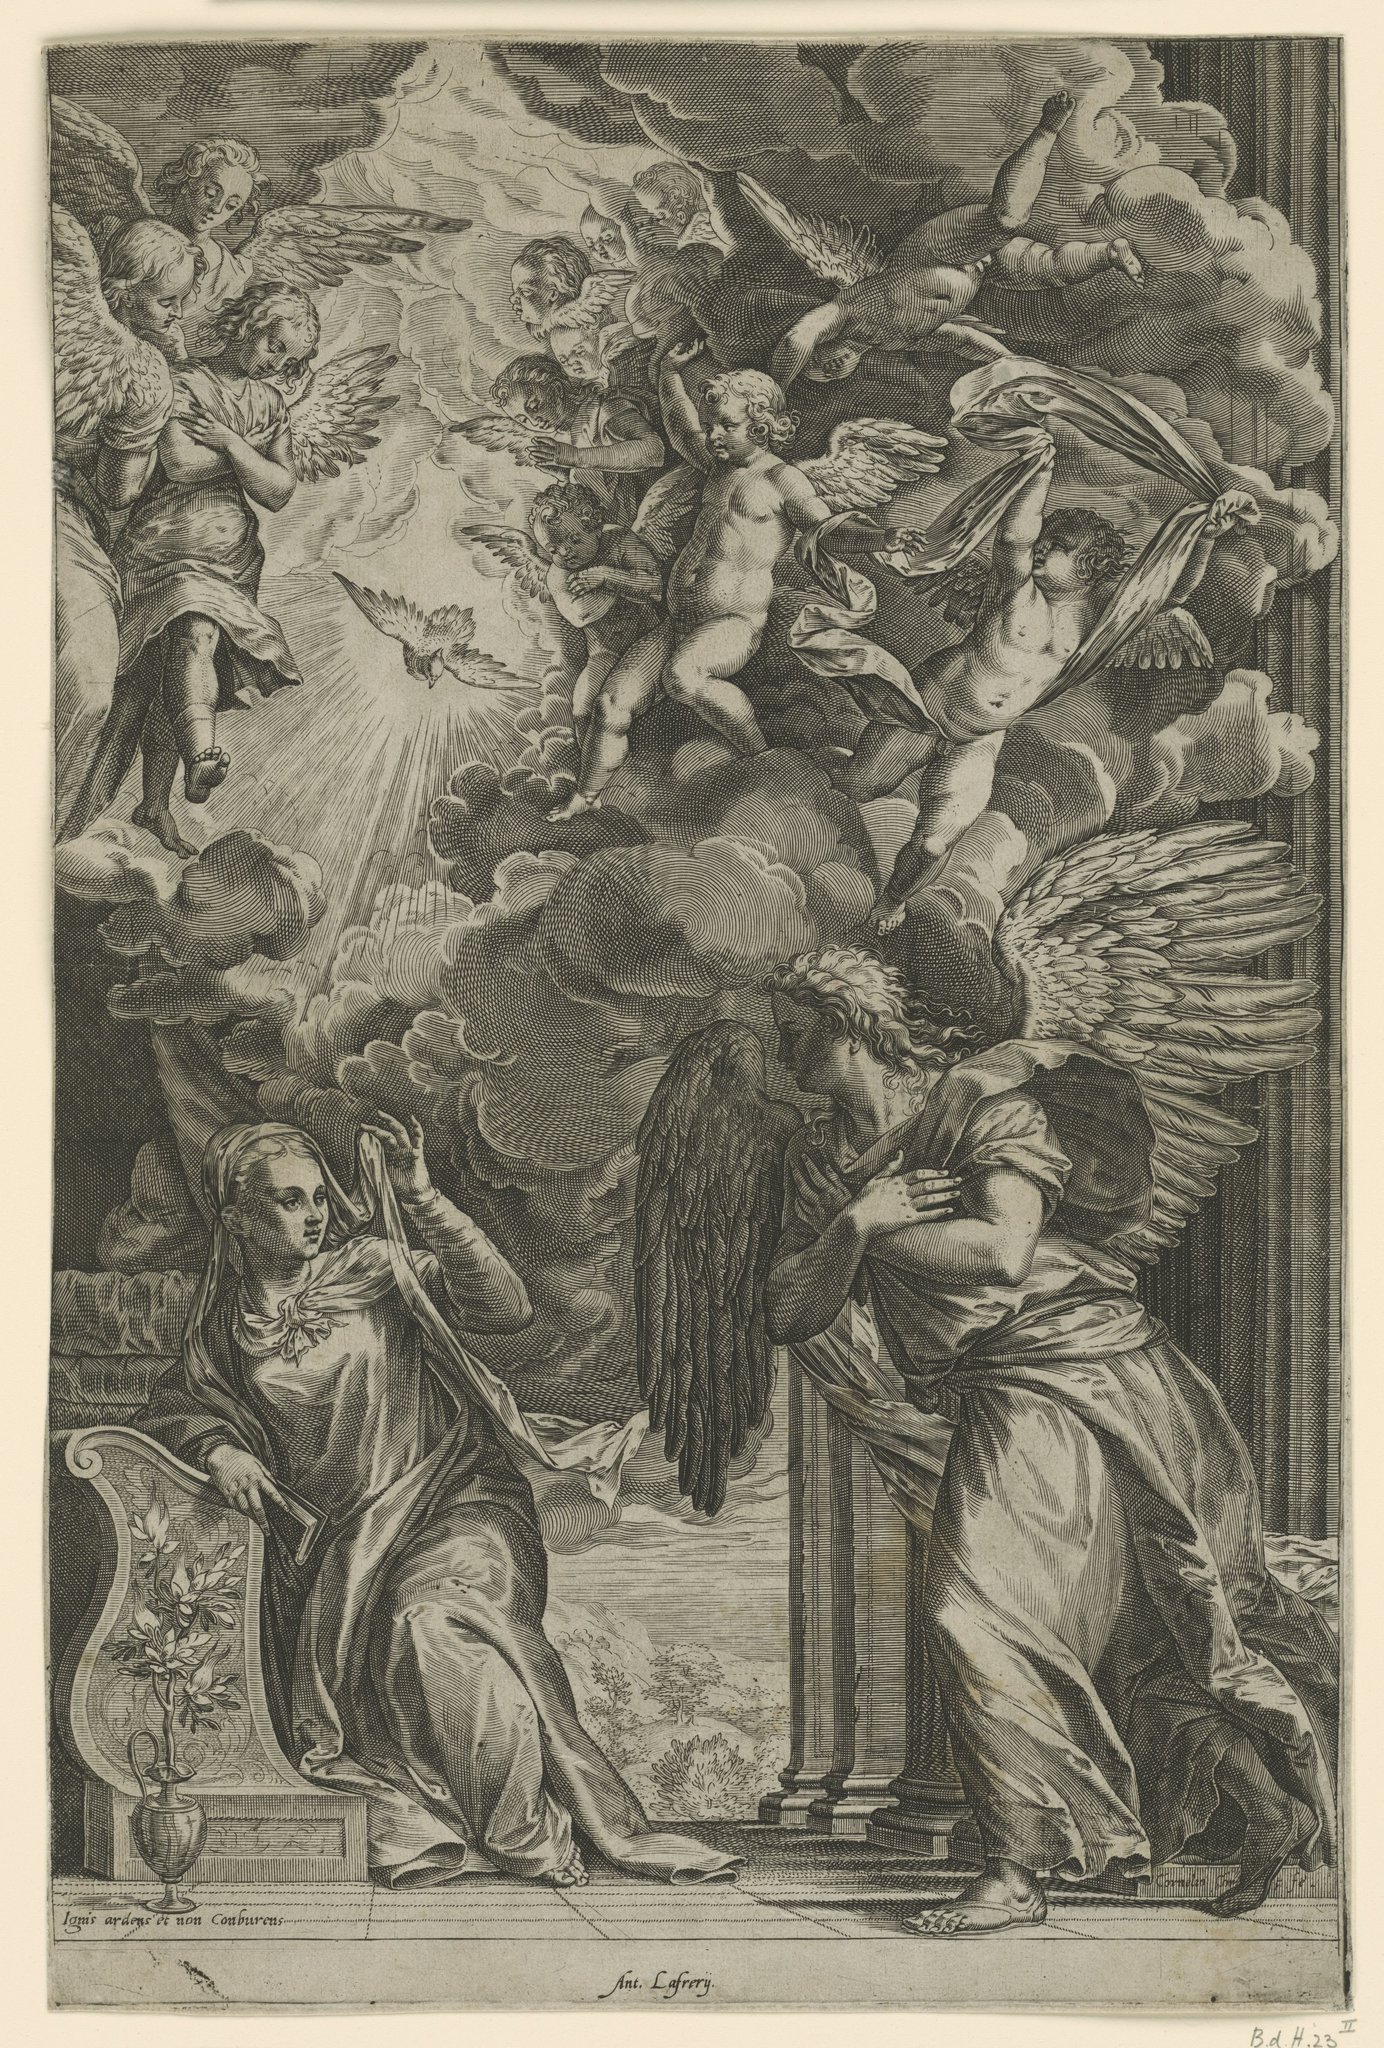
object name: print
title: Annunciatie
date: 1566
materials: paper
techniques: engraving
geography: italy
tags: the annunciation: mary kneeling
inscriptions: signature: ‘Cornelio Cort (fe(cit)’, collector's mark: Lugt 240, address: ‘Ant. lafrerij’, inscription: ‘Ignis ardens et non Conburens’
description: Maria zit geknield op een bidstoel. Ze kijkt om naar de engel Gabriël die achter haar staat. Naast de bidstoel een lelie in een vaas. In de wolken de Heilige Geest in de vorm van een duif en vele engeltjes.